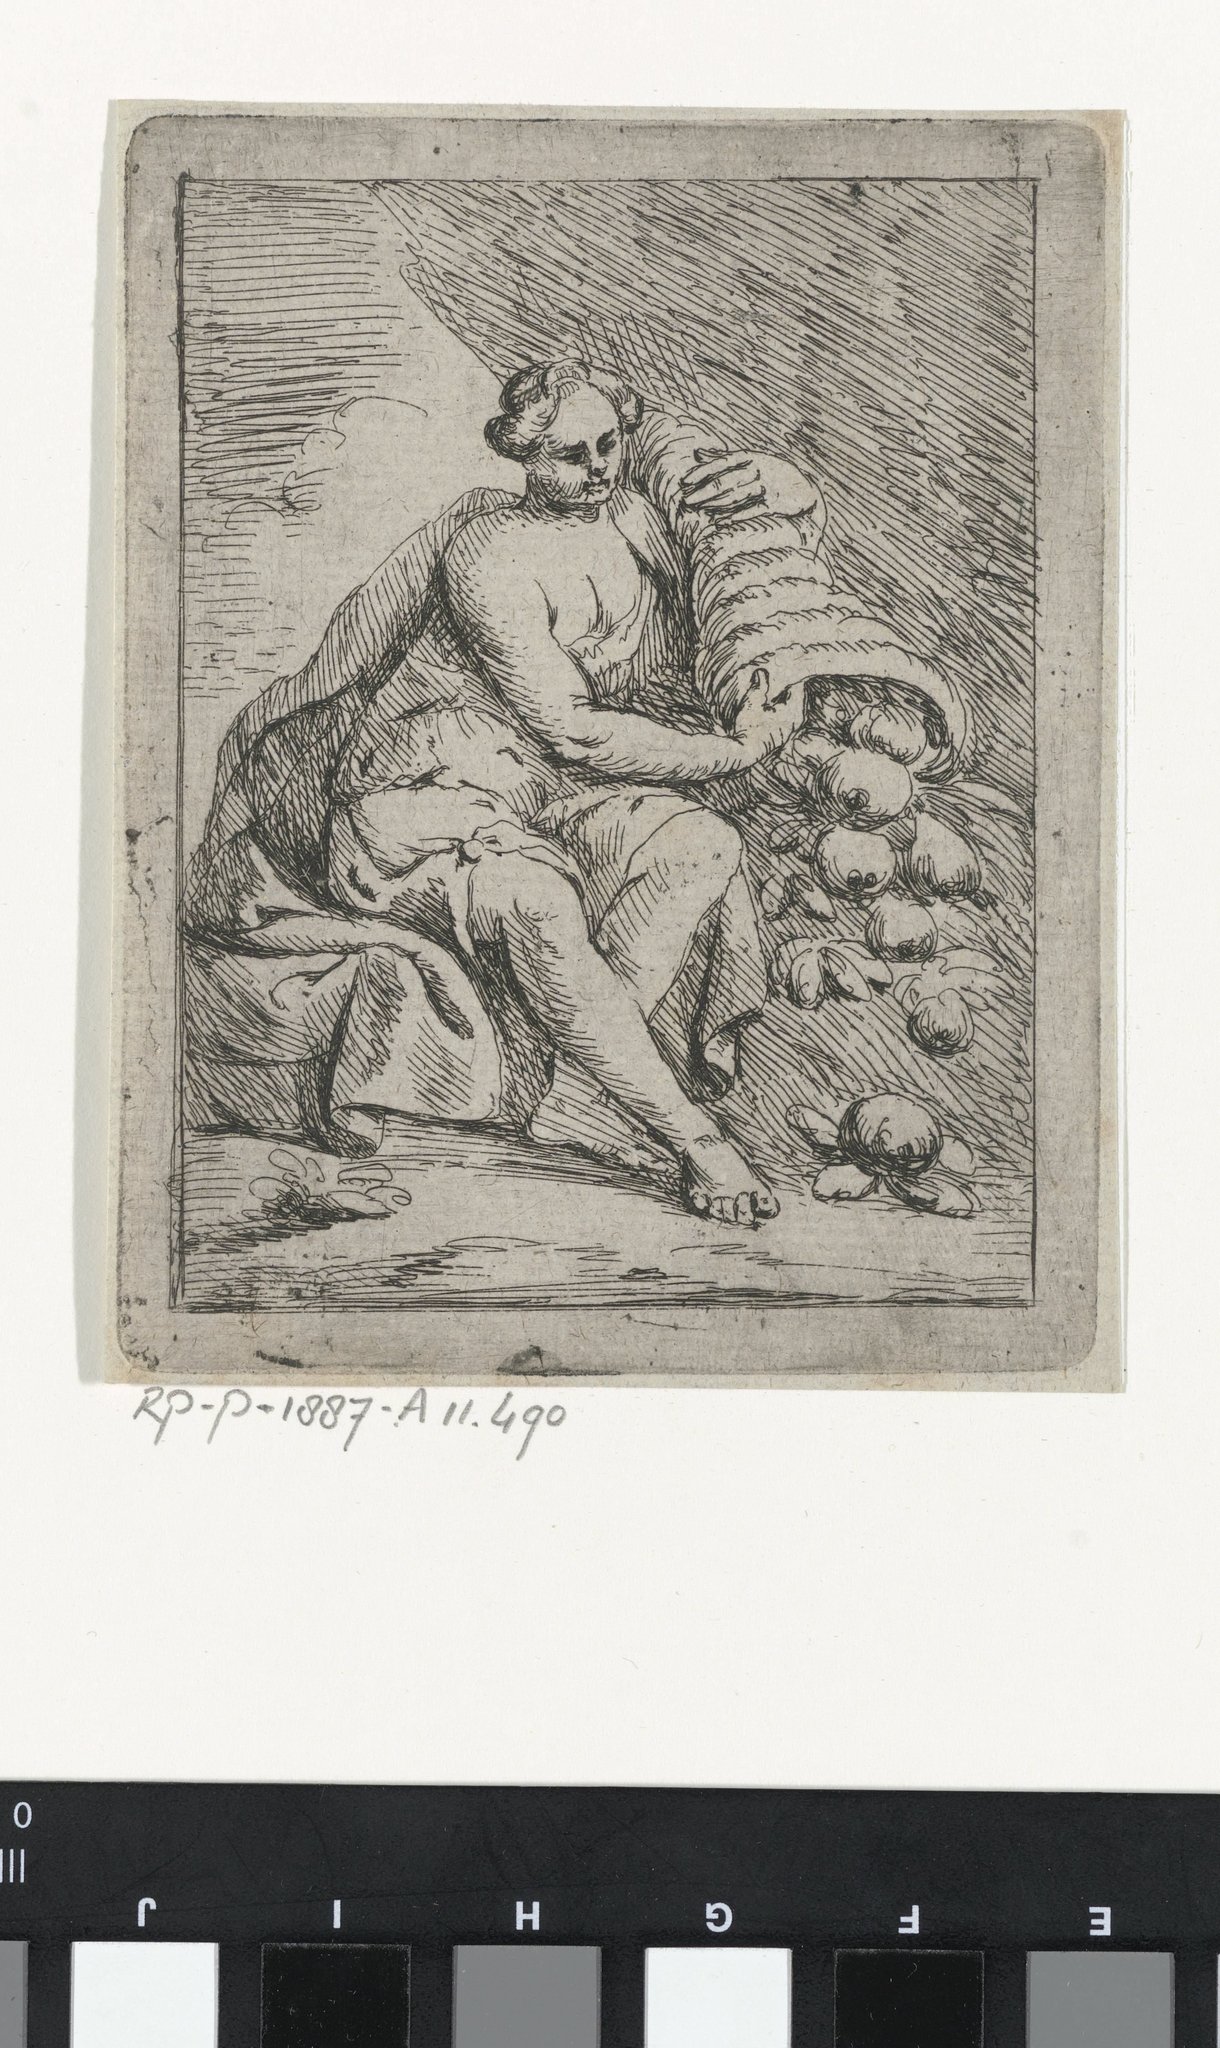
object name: print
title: Overvloed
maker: Anonymous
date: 1650-1750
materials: paper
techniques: etching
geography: netherlands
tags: abundance; 'abondanza', 'abondanza maritima' (ripa)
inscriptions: collector's mark: Lugt 2228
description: De personificatie van de Overvloed houdt een cornucopia, een hoorn des overvloeds, in de handen.